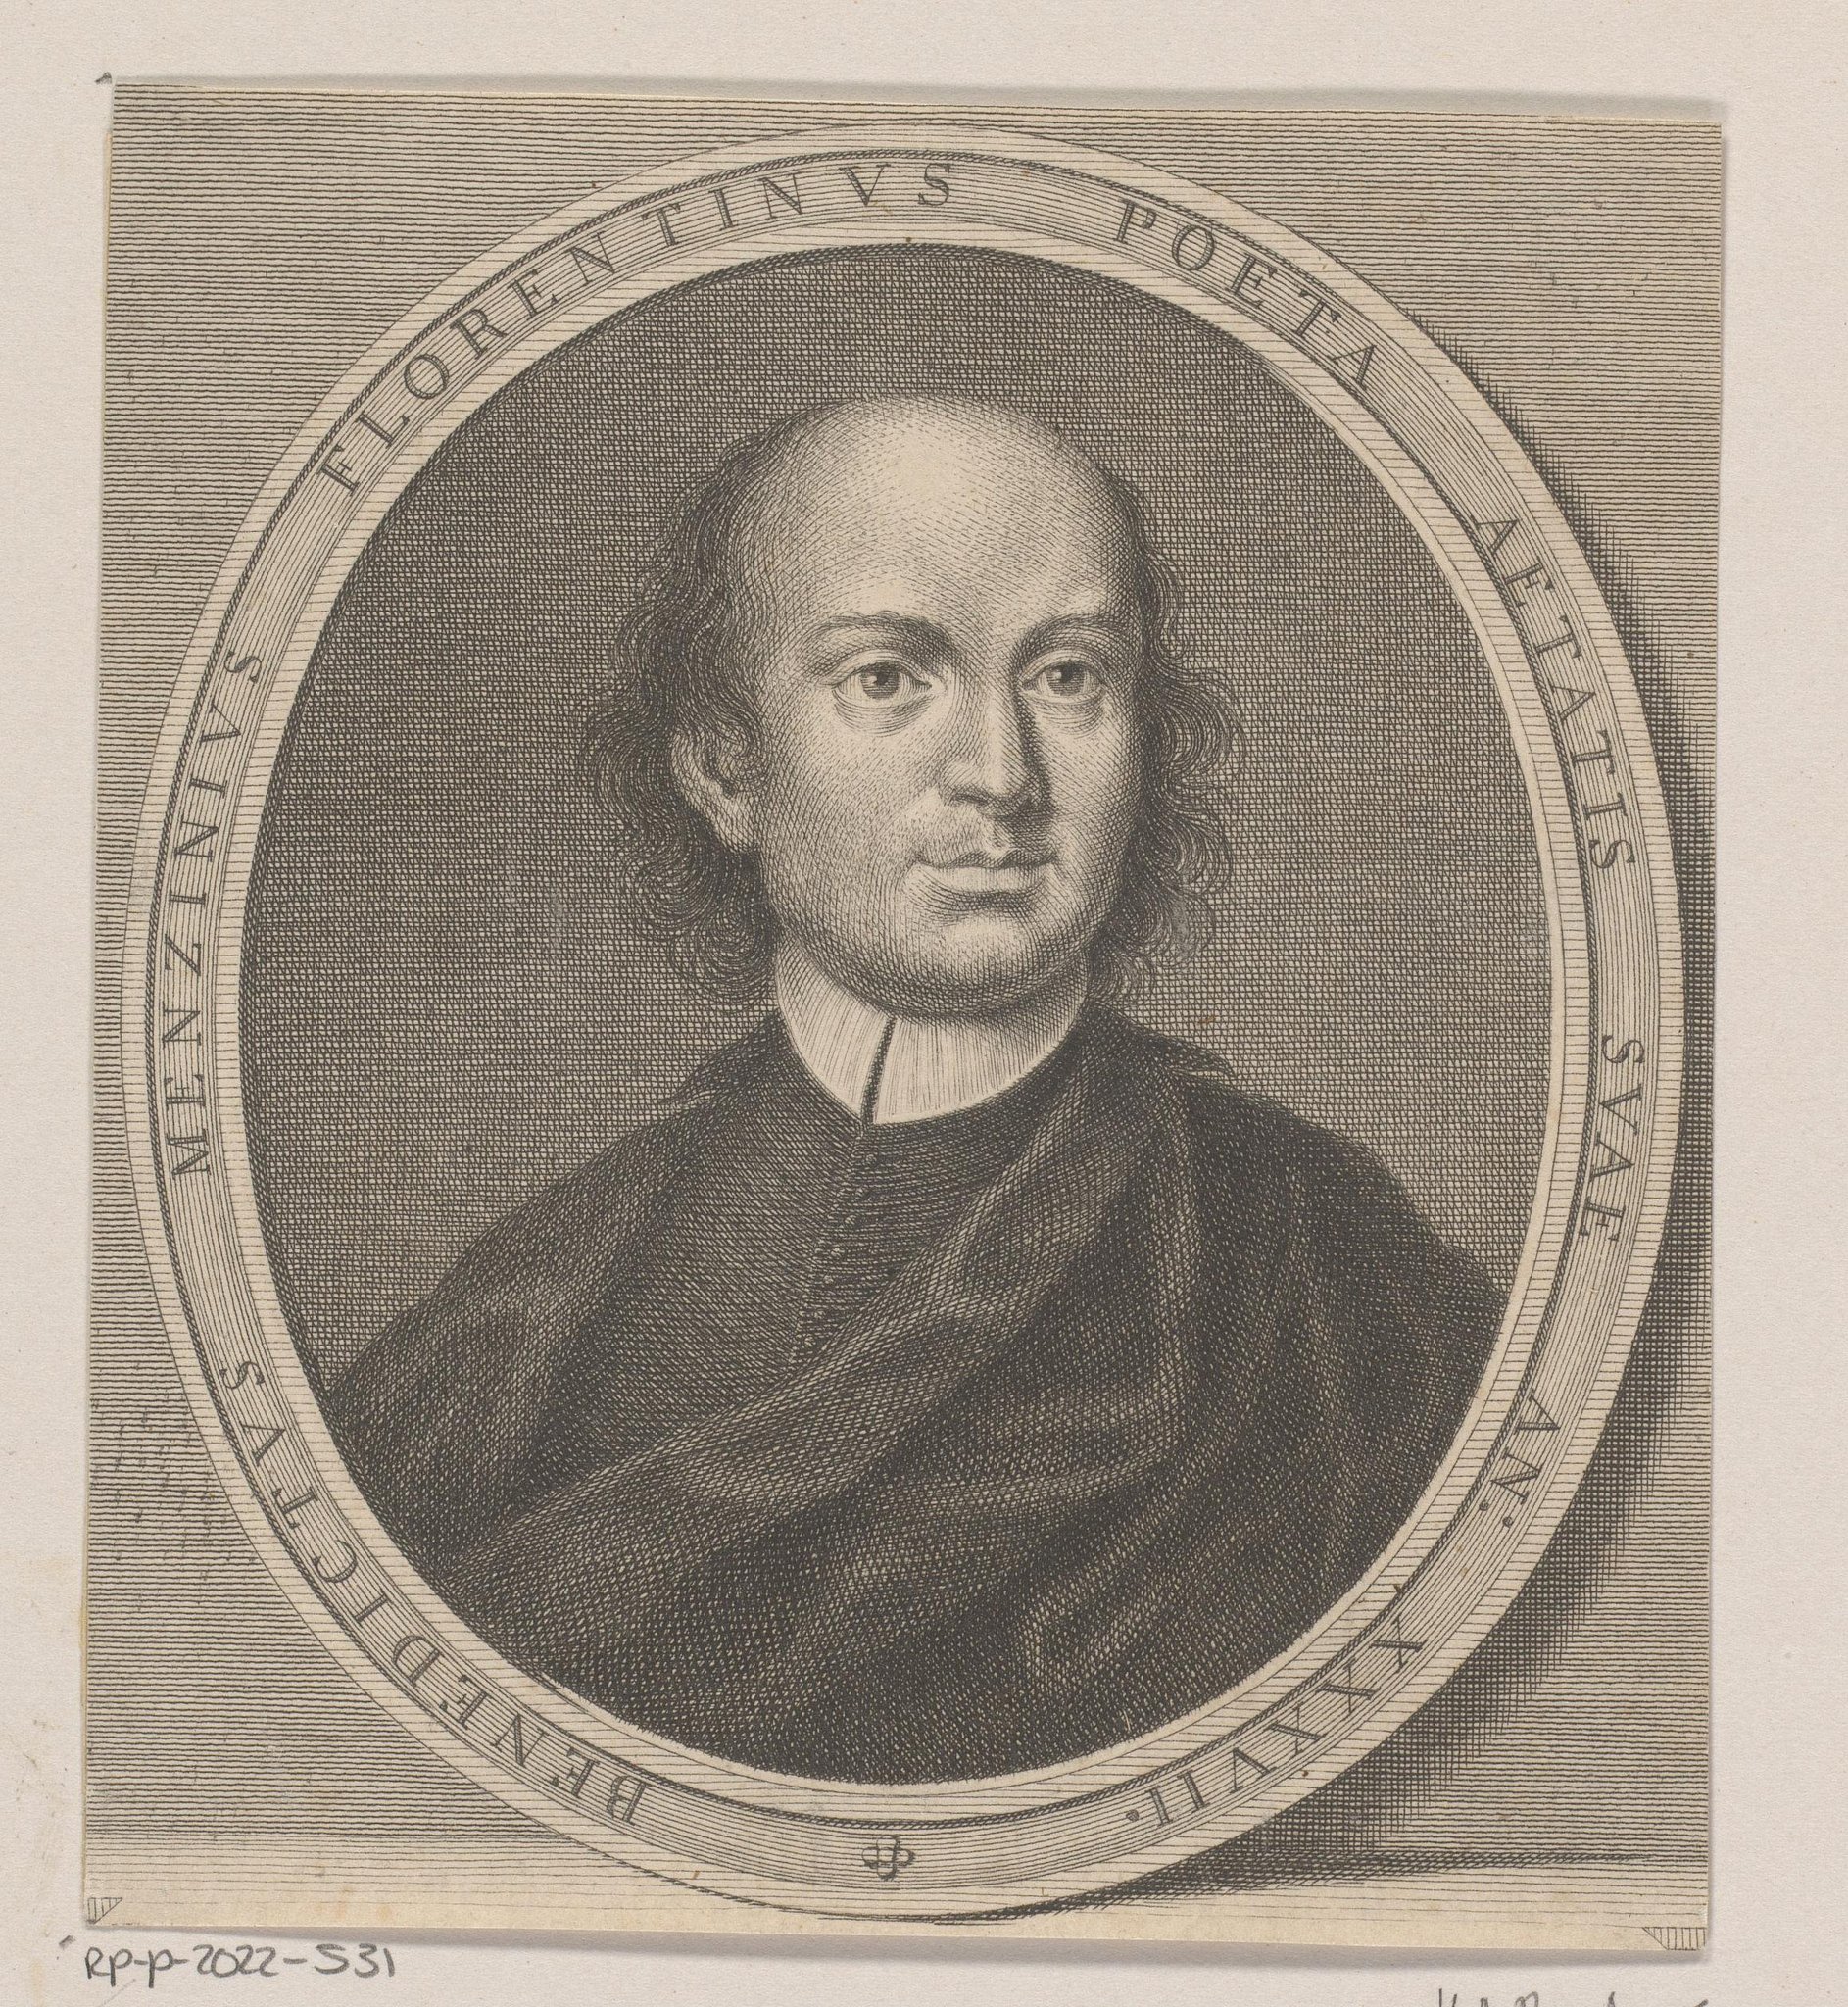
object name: print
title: Portret van Benedetto Menzini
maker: Anonymous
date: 1670-1750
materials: paper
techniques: engraving, etching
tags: rome, priest, historical persons